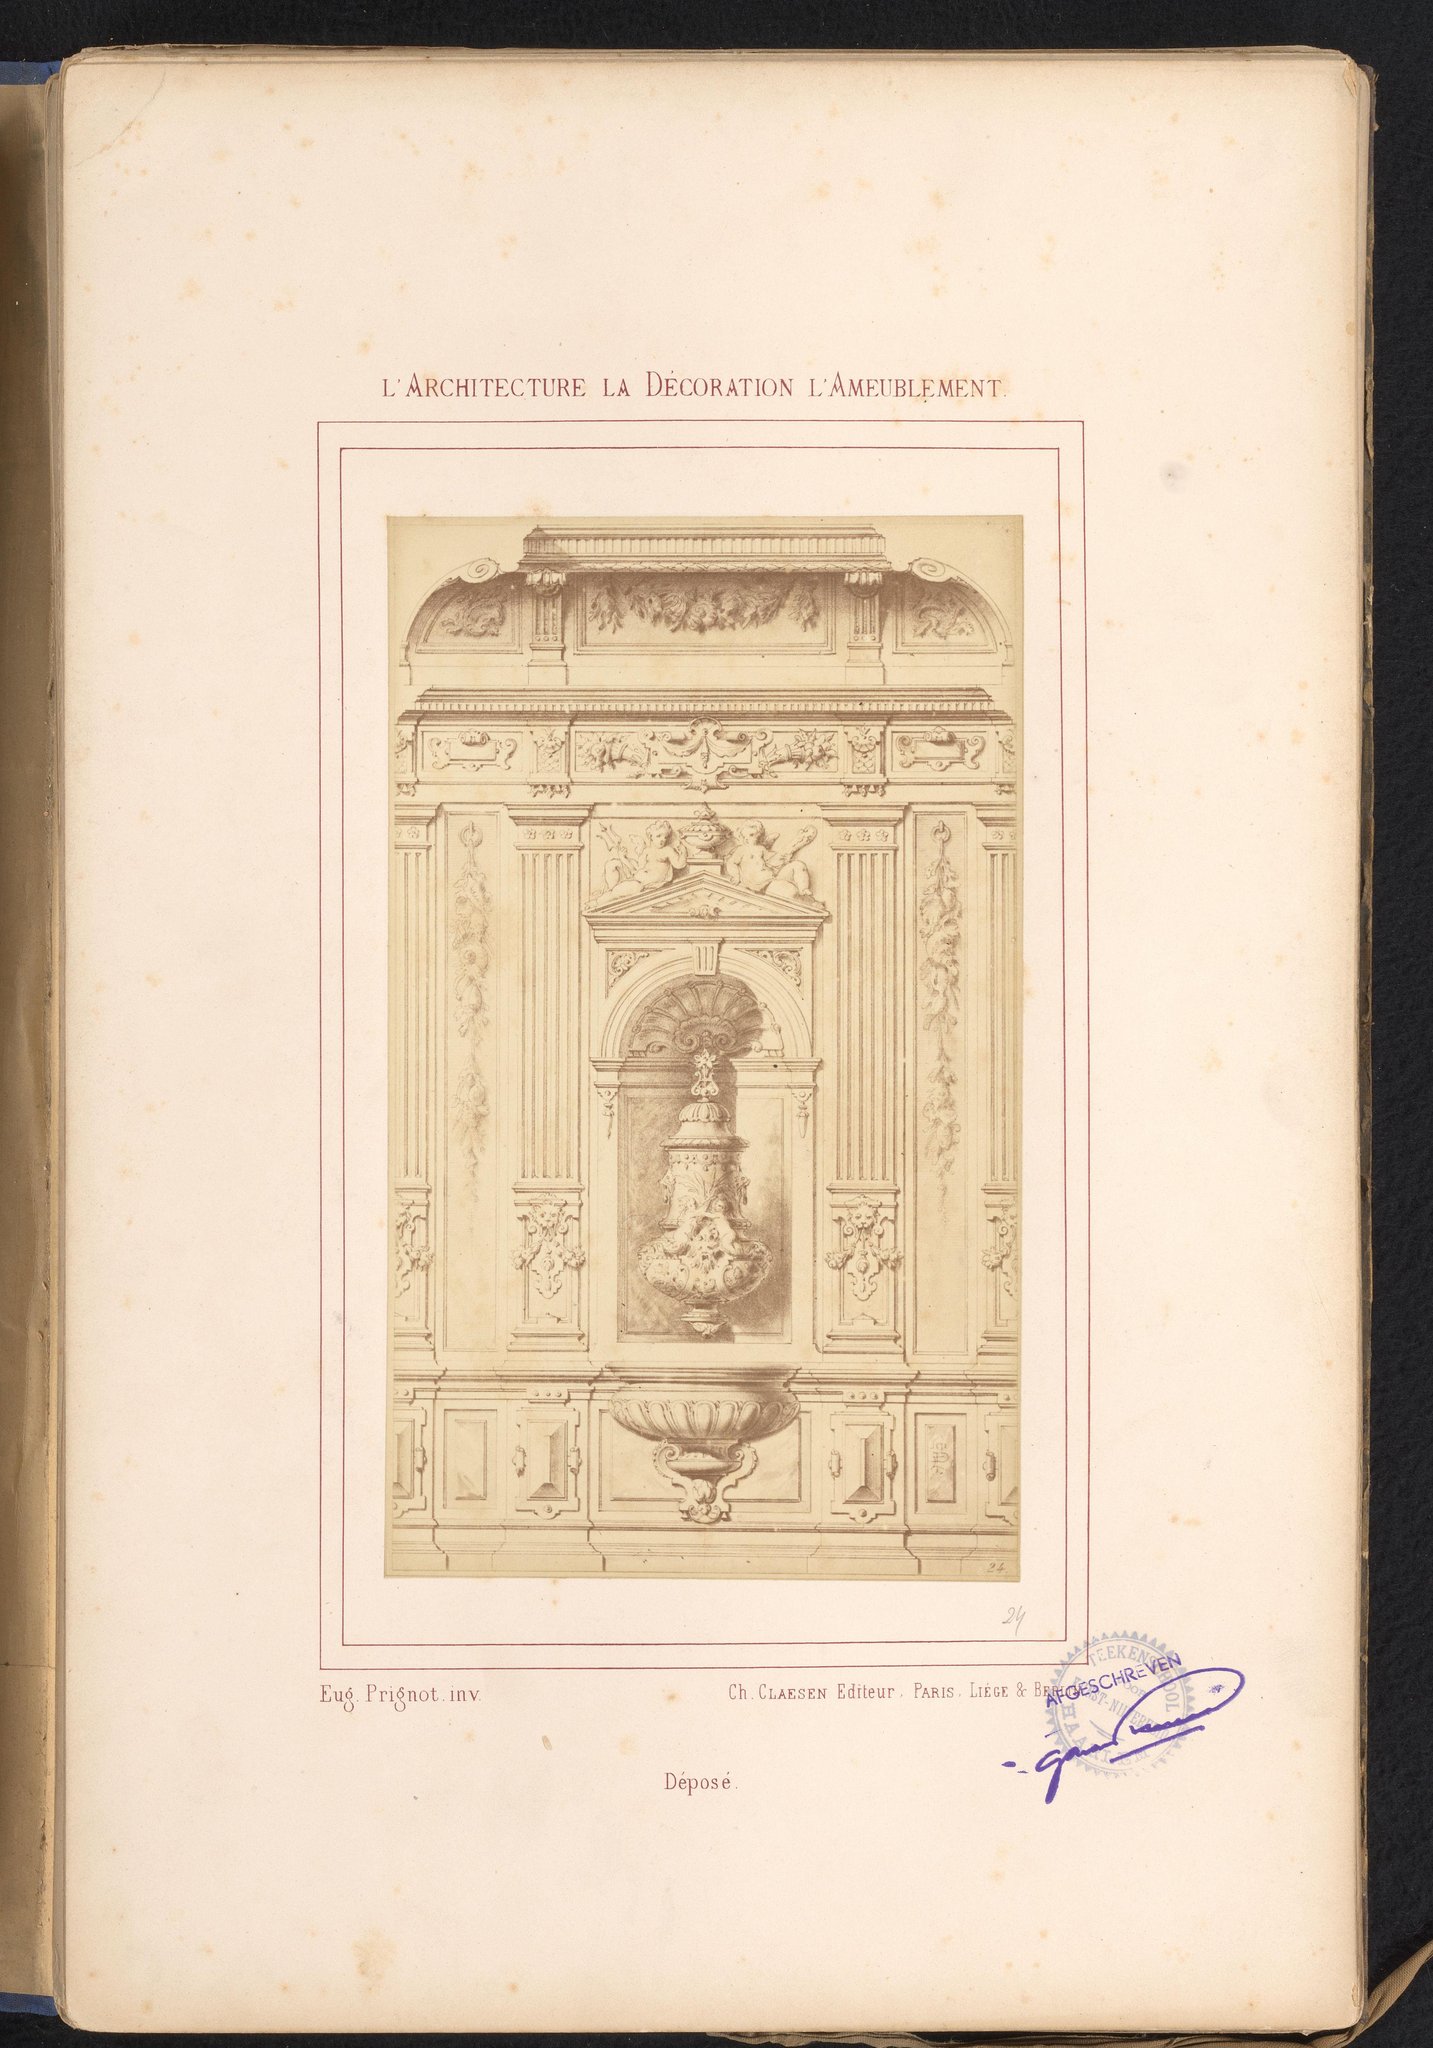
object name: reproduction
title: Fotoreproductie van een ontwerp voor een fonteintje in een wanddecoratie naar Alexandre Eugène Prignot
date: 1873-1880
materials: cardboard, paper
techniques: albumen print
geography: liège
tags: fountain (indoors), wall-covering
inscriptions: inscription: ‘Eug. Prignot. inv.’, stamp: ‘TEEKENSCHOOL/ VOOR/ KUNST-NIJVERHEID/ HAARLEM’, inscription: ‘Déposé’, number: ‘24’, stamp: ‘AFGESCHREVEN/ [...]’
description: Deze foto maakt deel uit van een omslag met 61 foto's op 61 bladen.